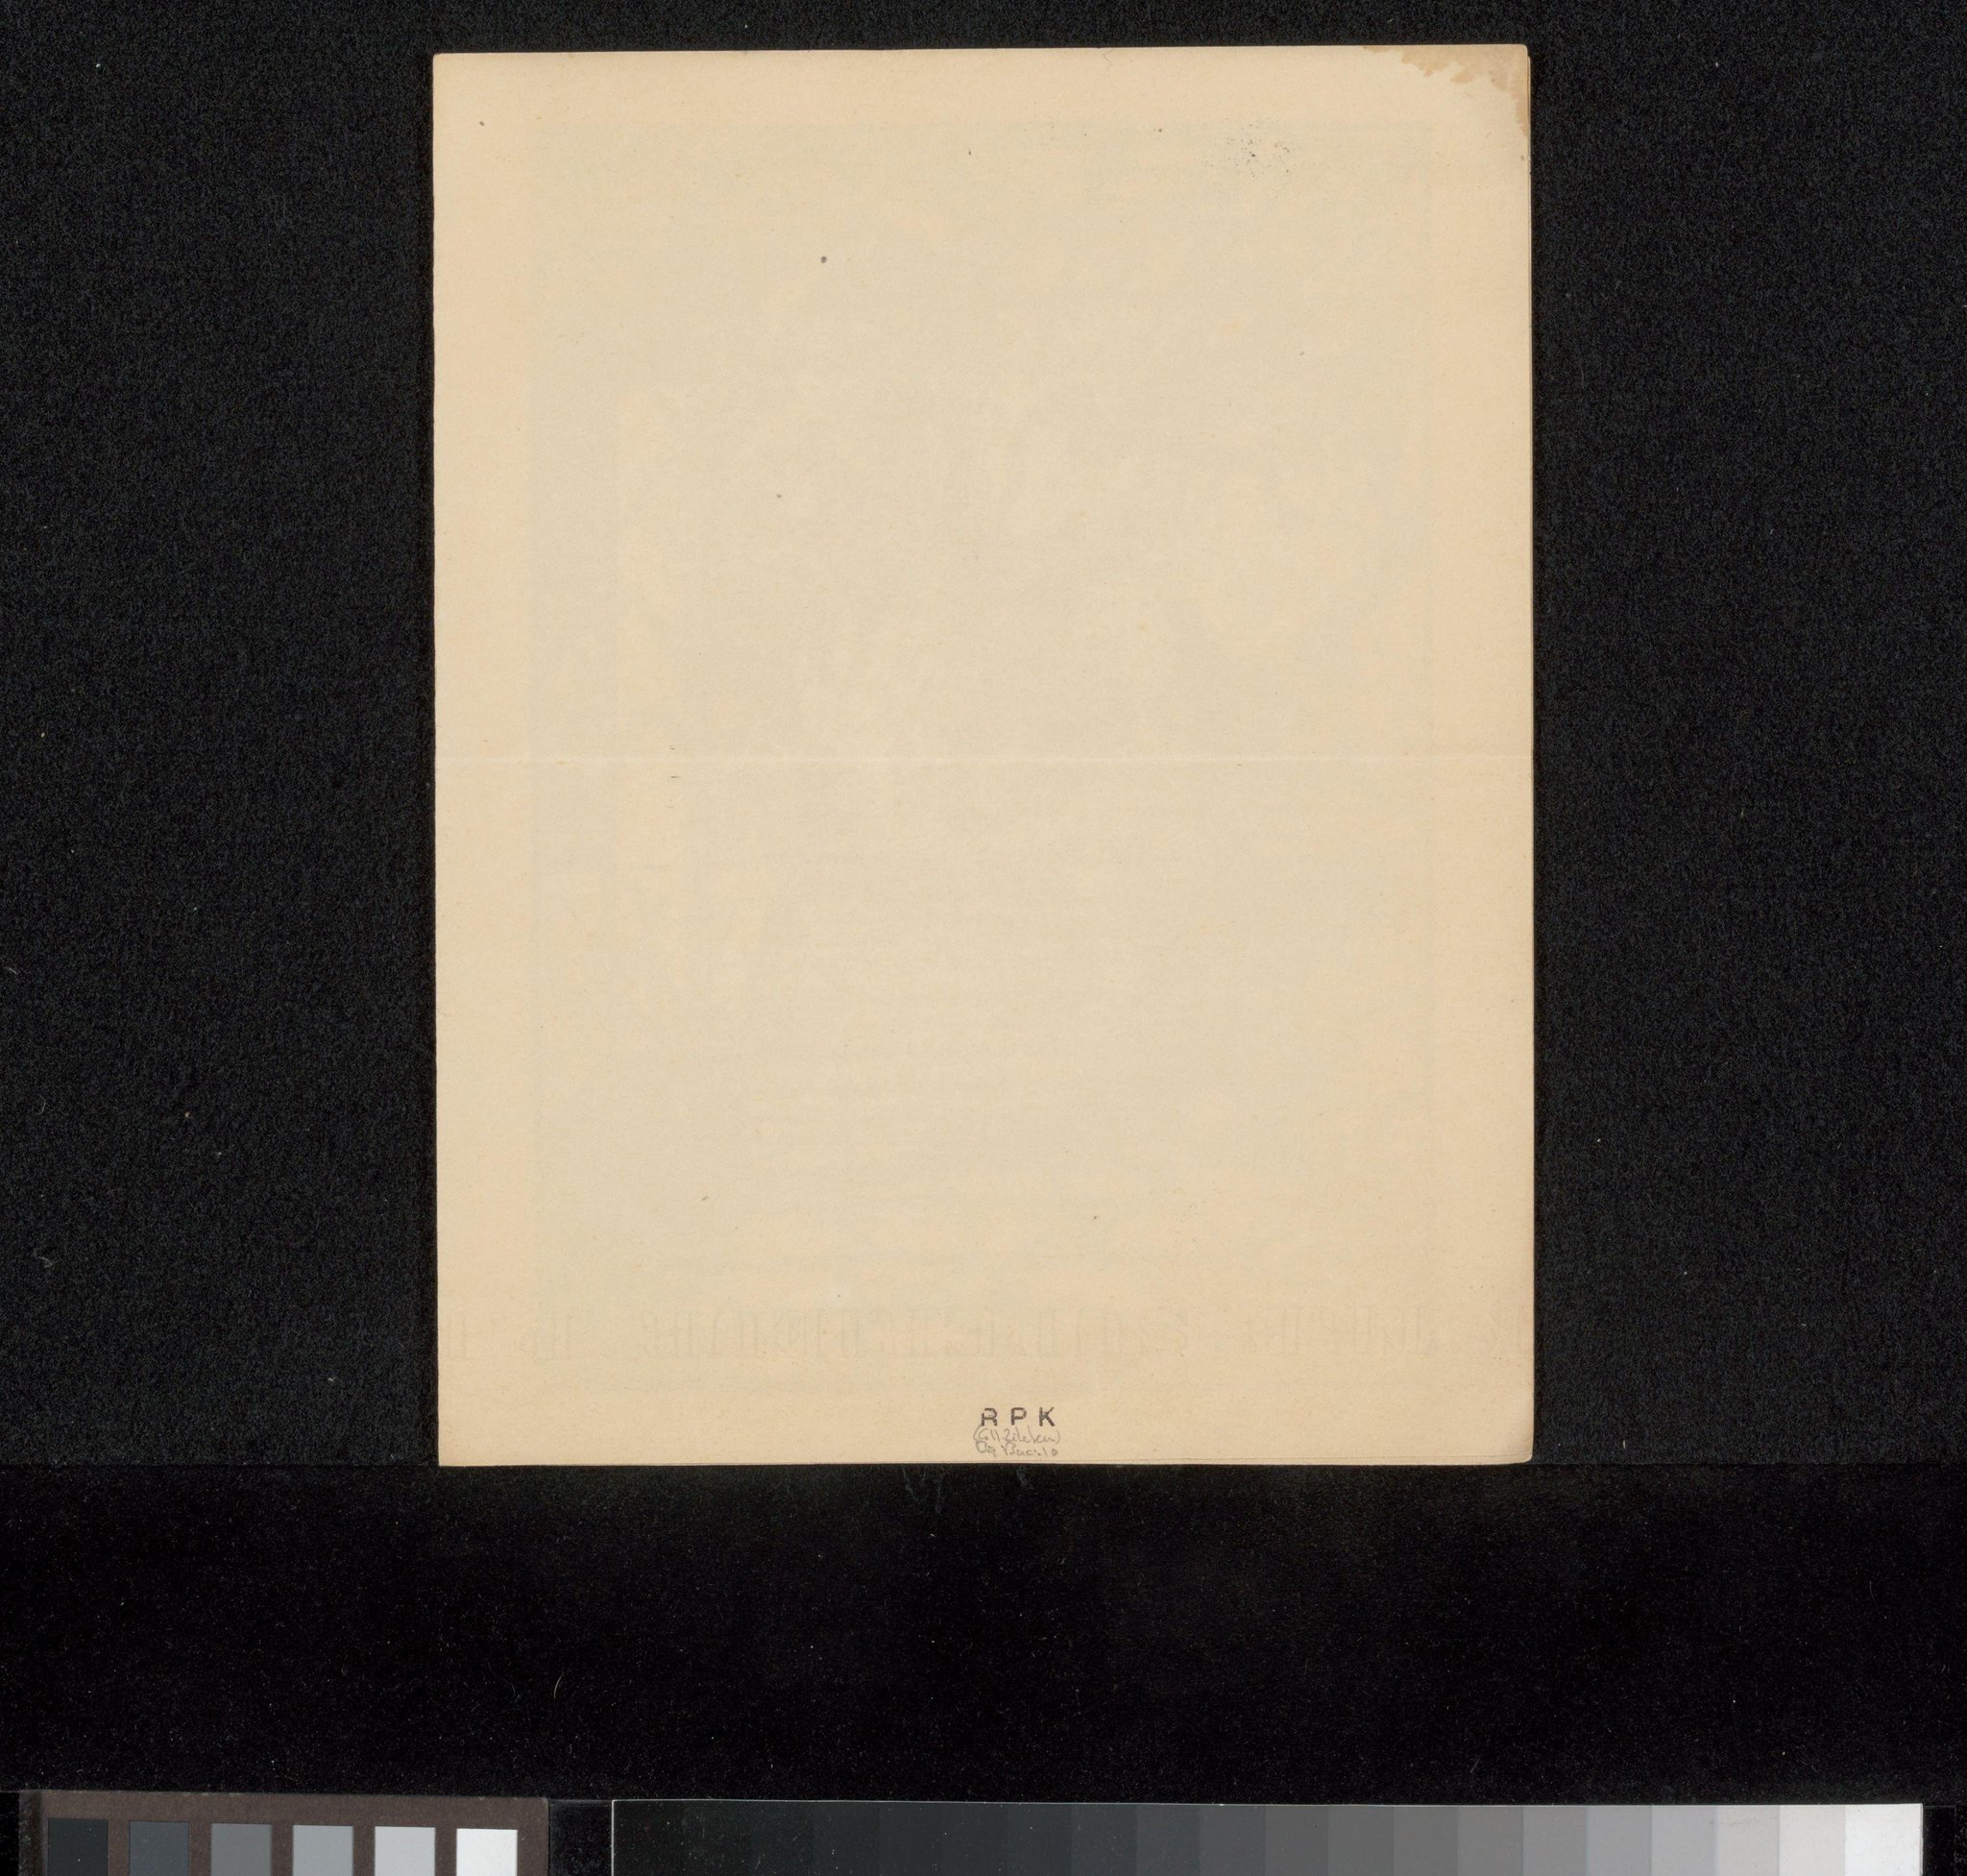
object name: letter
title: Brief aan Philip Zilcken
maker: ferdinand-sigismund bac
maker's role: draughtsman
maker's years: 1859-1952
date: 1926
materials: ink, paper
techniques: pen, printing, writing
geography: menton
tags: painter, draughtsman, philip zilcken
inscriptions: collector's mark: ‘RPK’